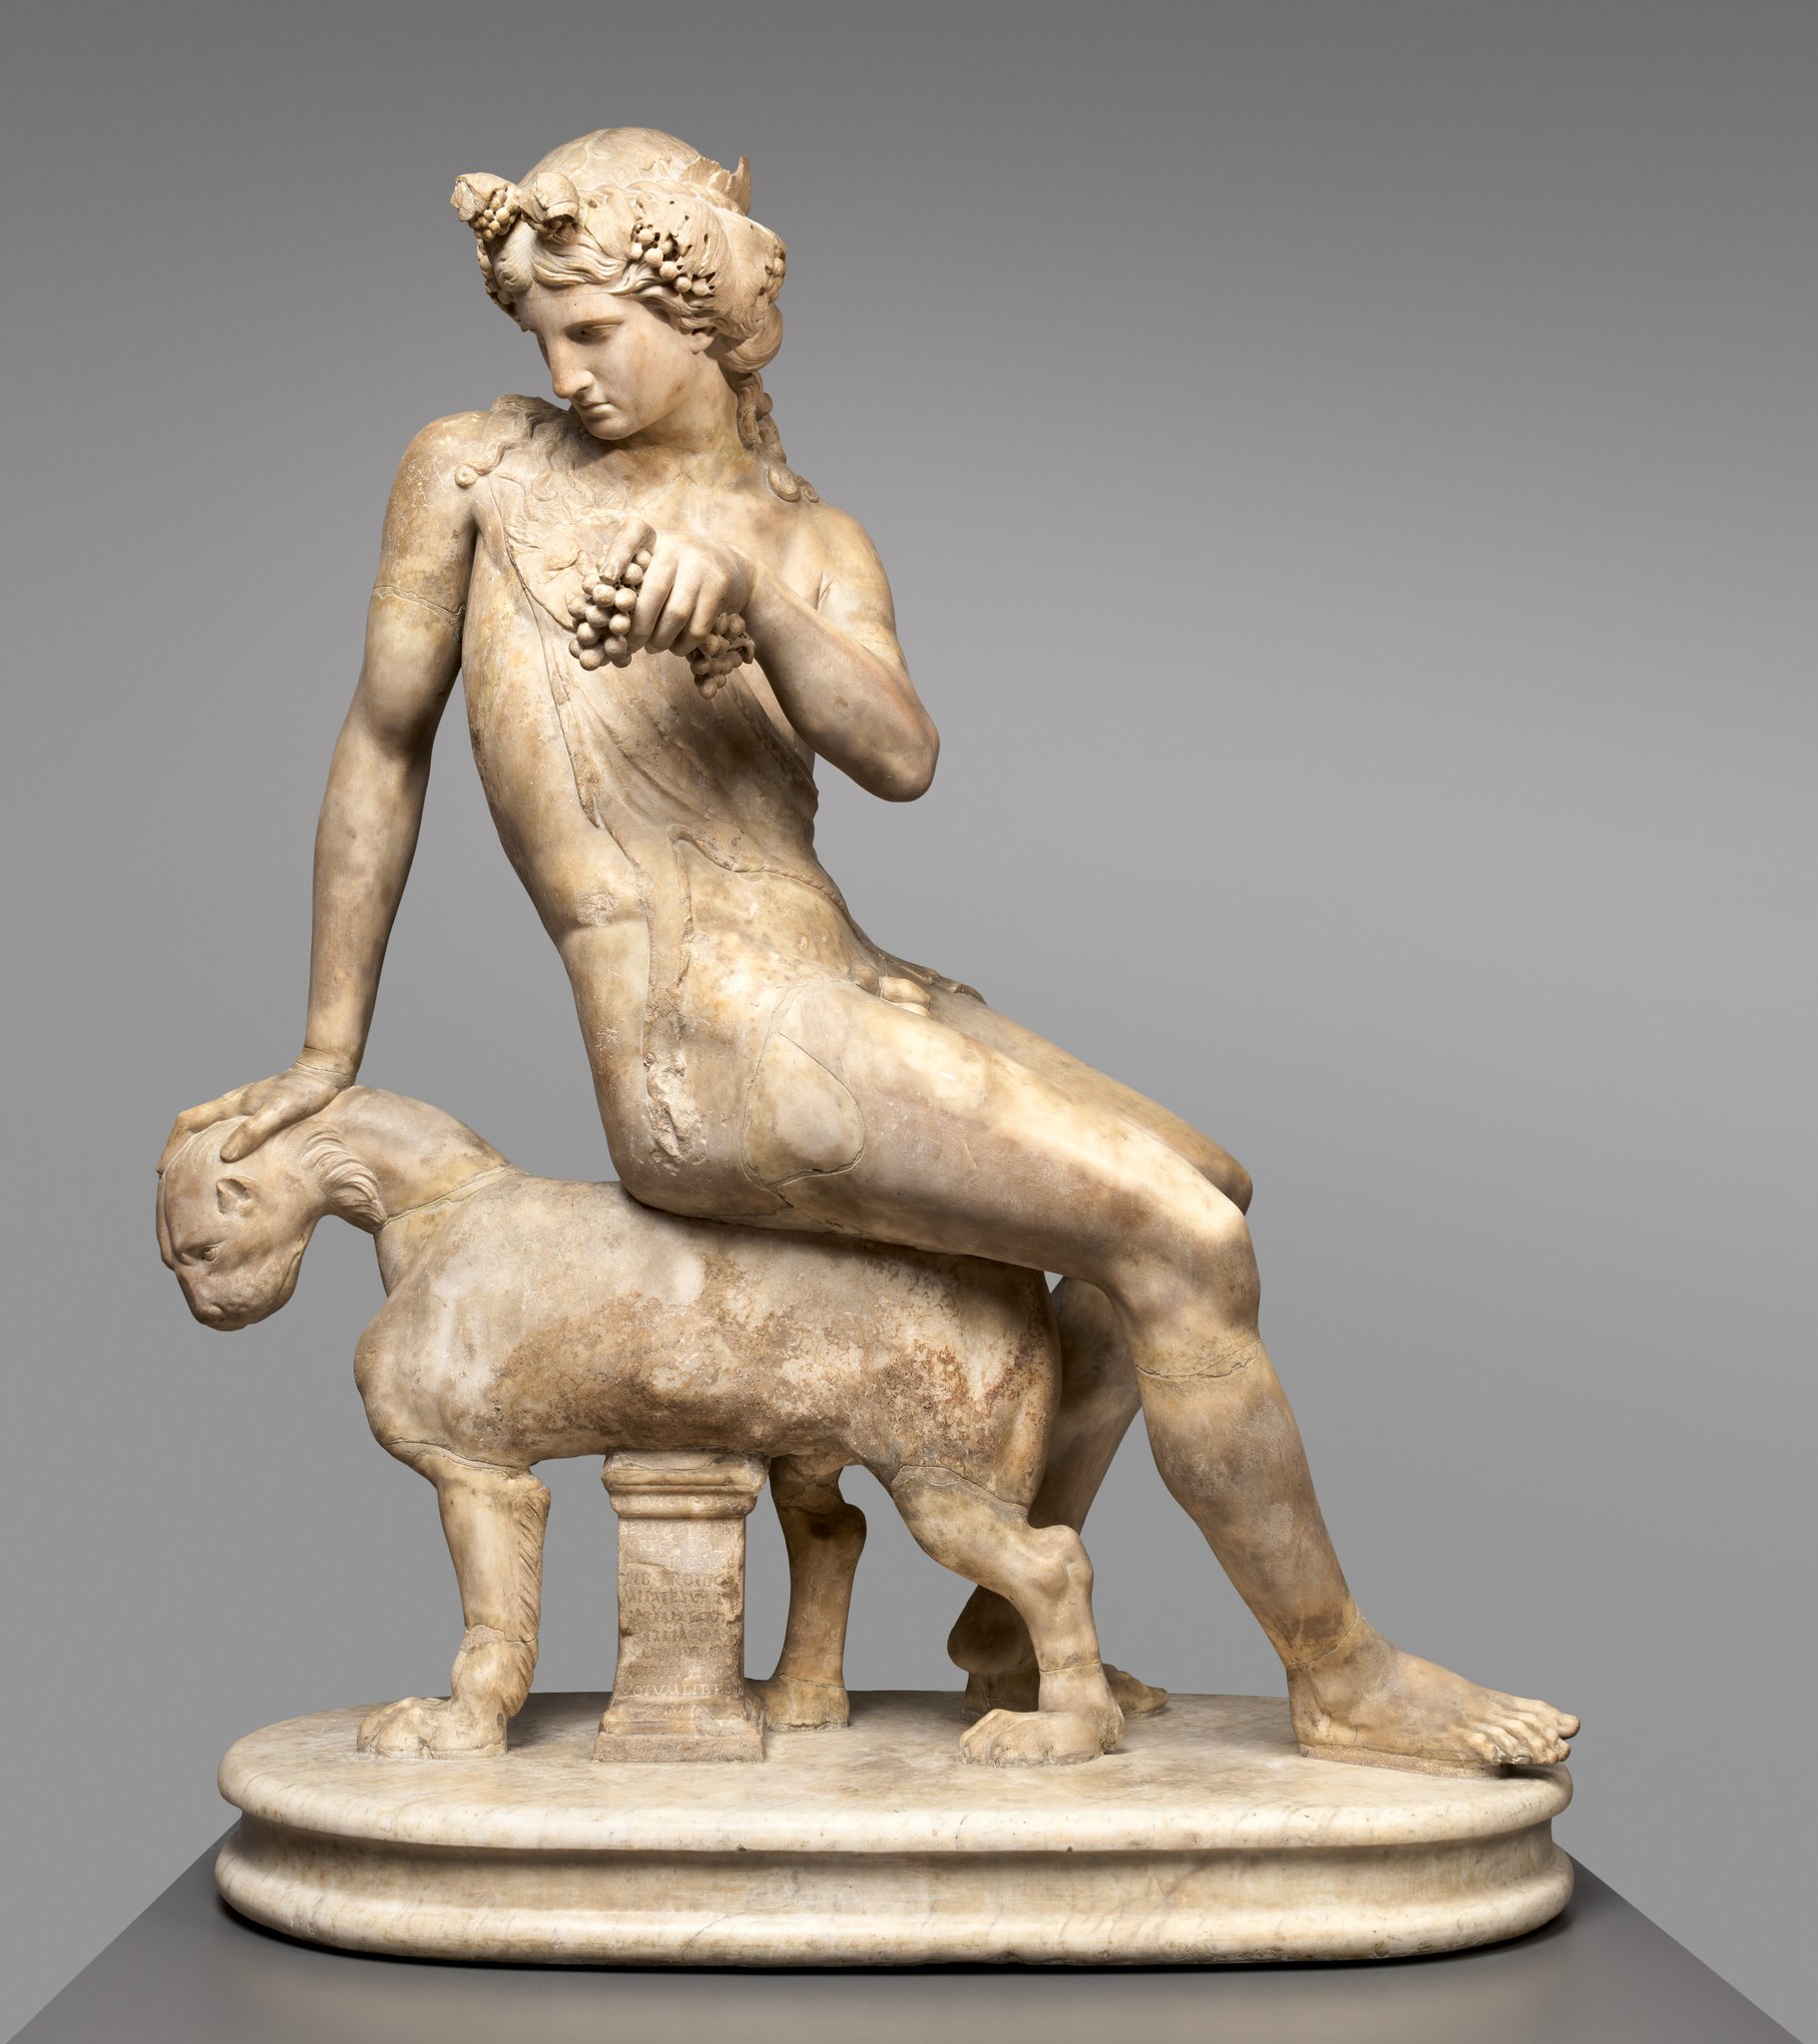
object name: statue of dionysos on a panther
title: Marble statue of Dionysos seated on a panther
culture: roman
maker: françois duquesnoy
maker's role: artist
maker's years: 1594-1643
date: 1-300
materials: marble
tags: animals,dionysus